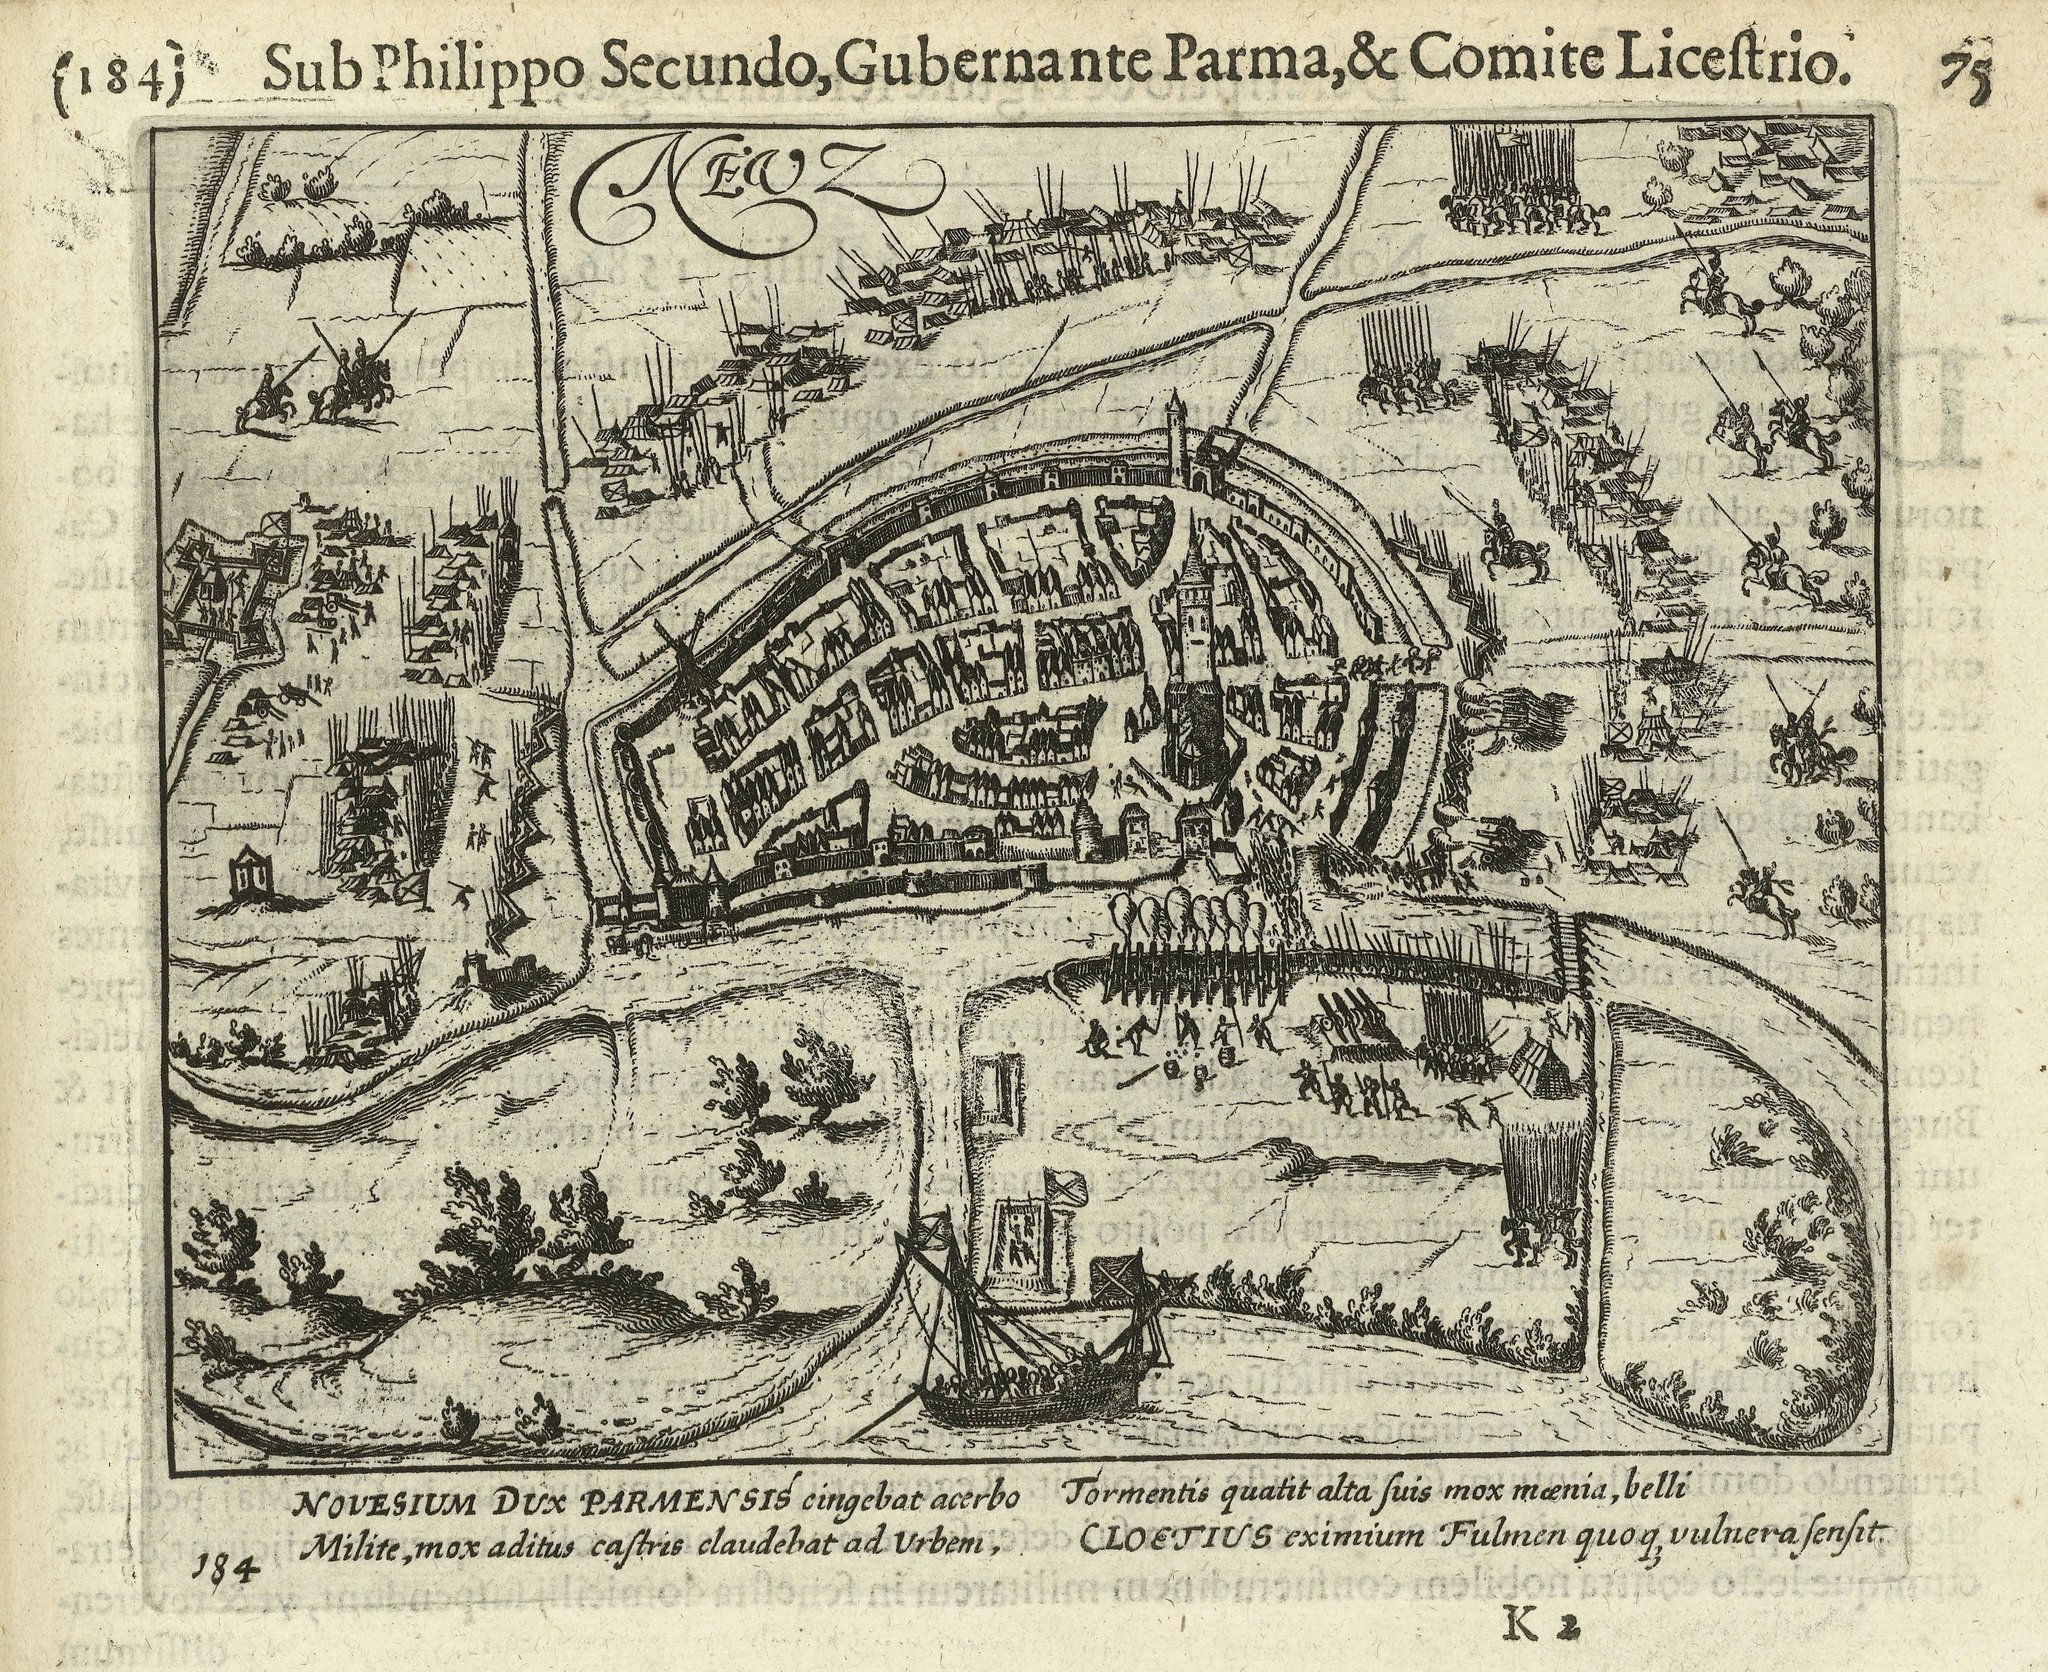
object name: print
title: Beleg van Neuss door Parma, 1586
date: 1613-1615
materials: paper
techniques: etching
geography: amsterdam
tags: alessandro farnese (landvoogd van de nederlanden en hertog van parma en piacenza), siege, position war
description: Beleg van Neuss door de hertog van Parma, 1586. Plan van de stad met de belegerende troepen om de stad. Met onderschrift van 4 regels in het Latijn. Genummerd 184. Bedrukt op achterzijde met tekst in het Latijn.